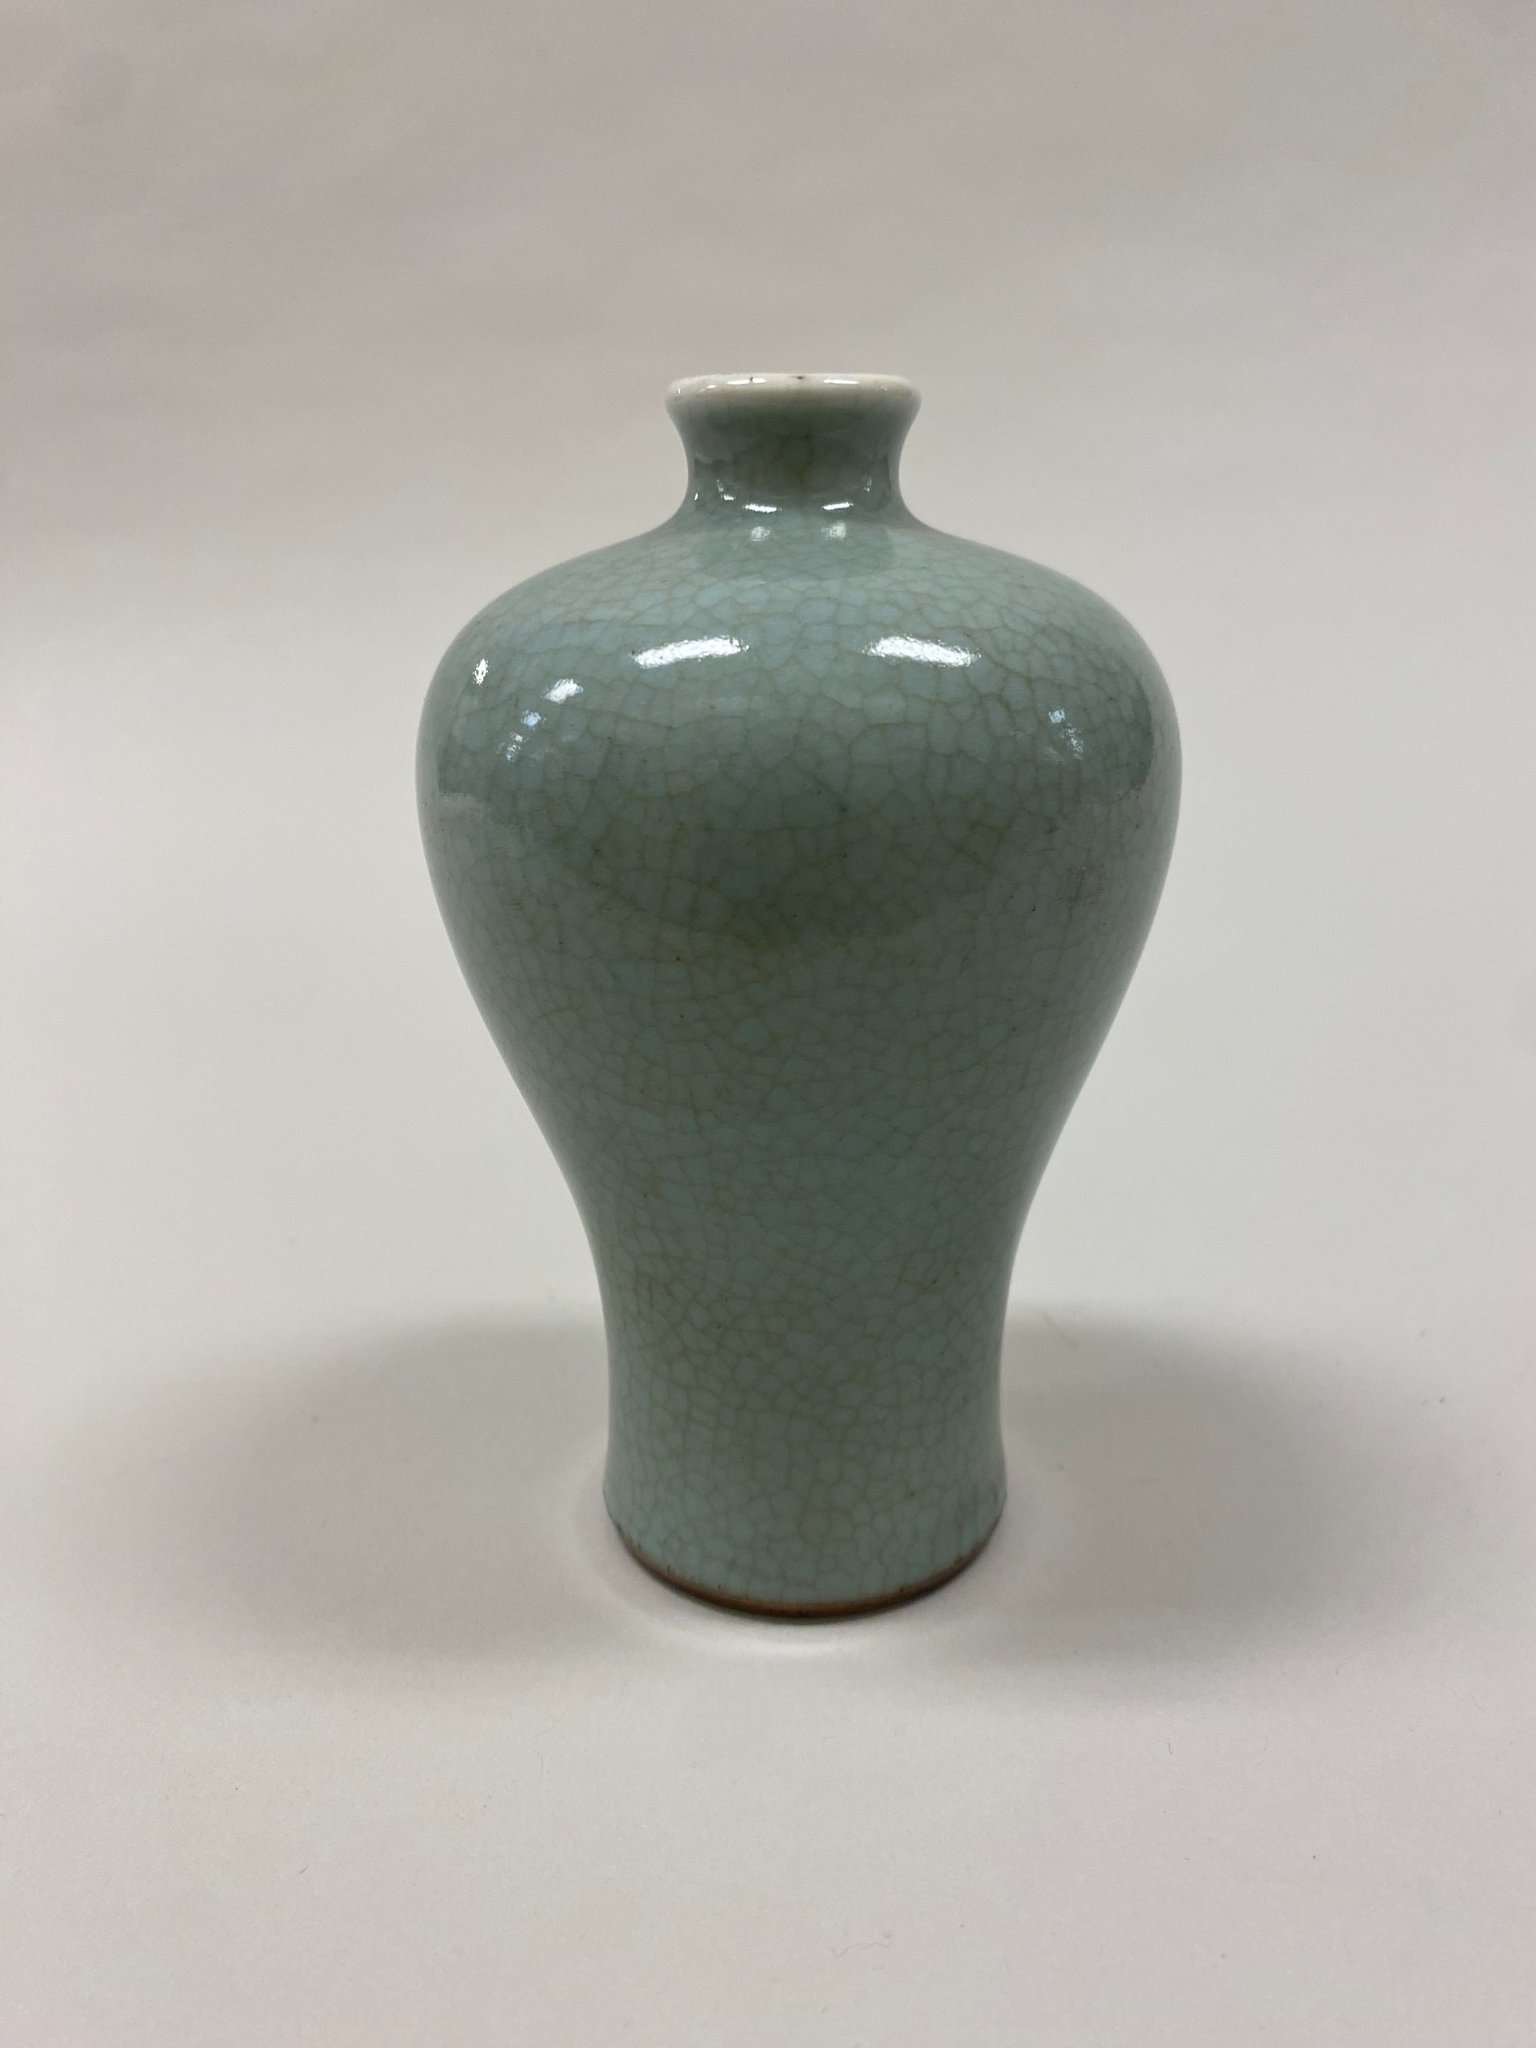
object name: gallipot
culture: chinese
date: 1736-1795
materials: glaze, porcelain